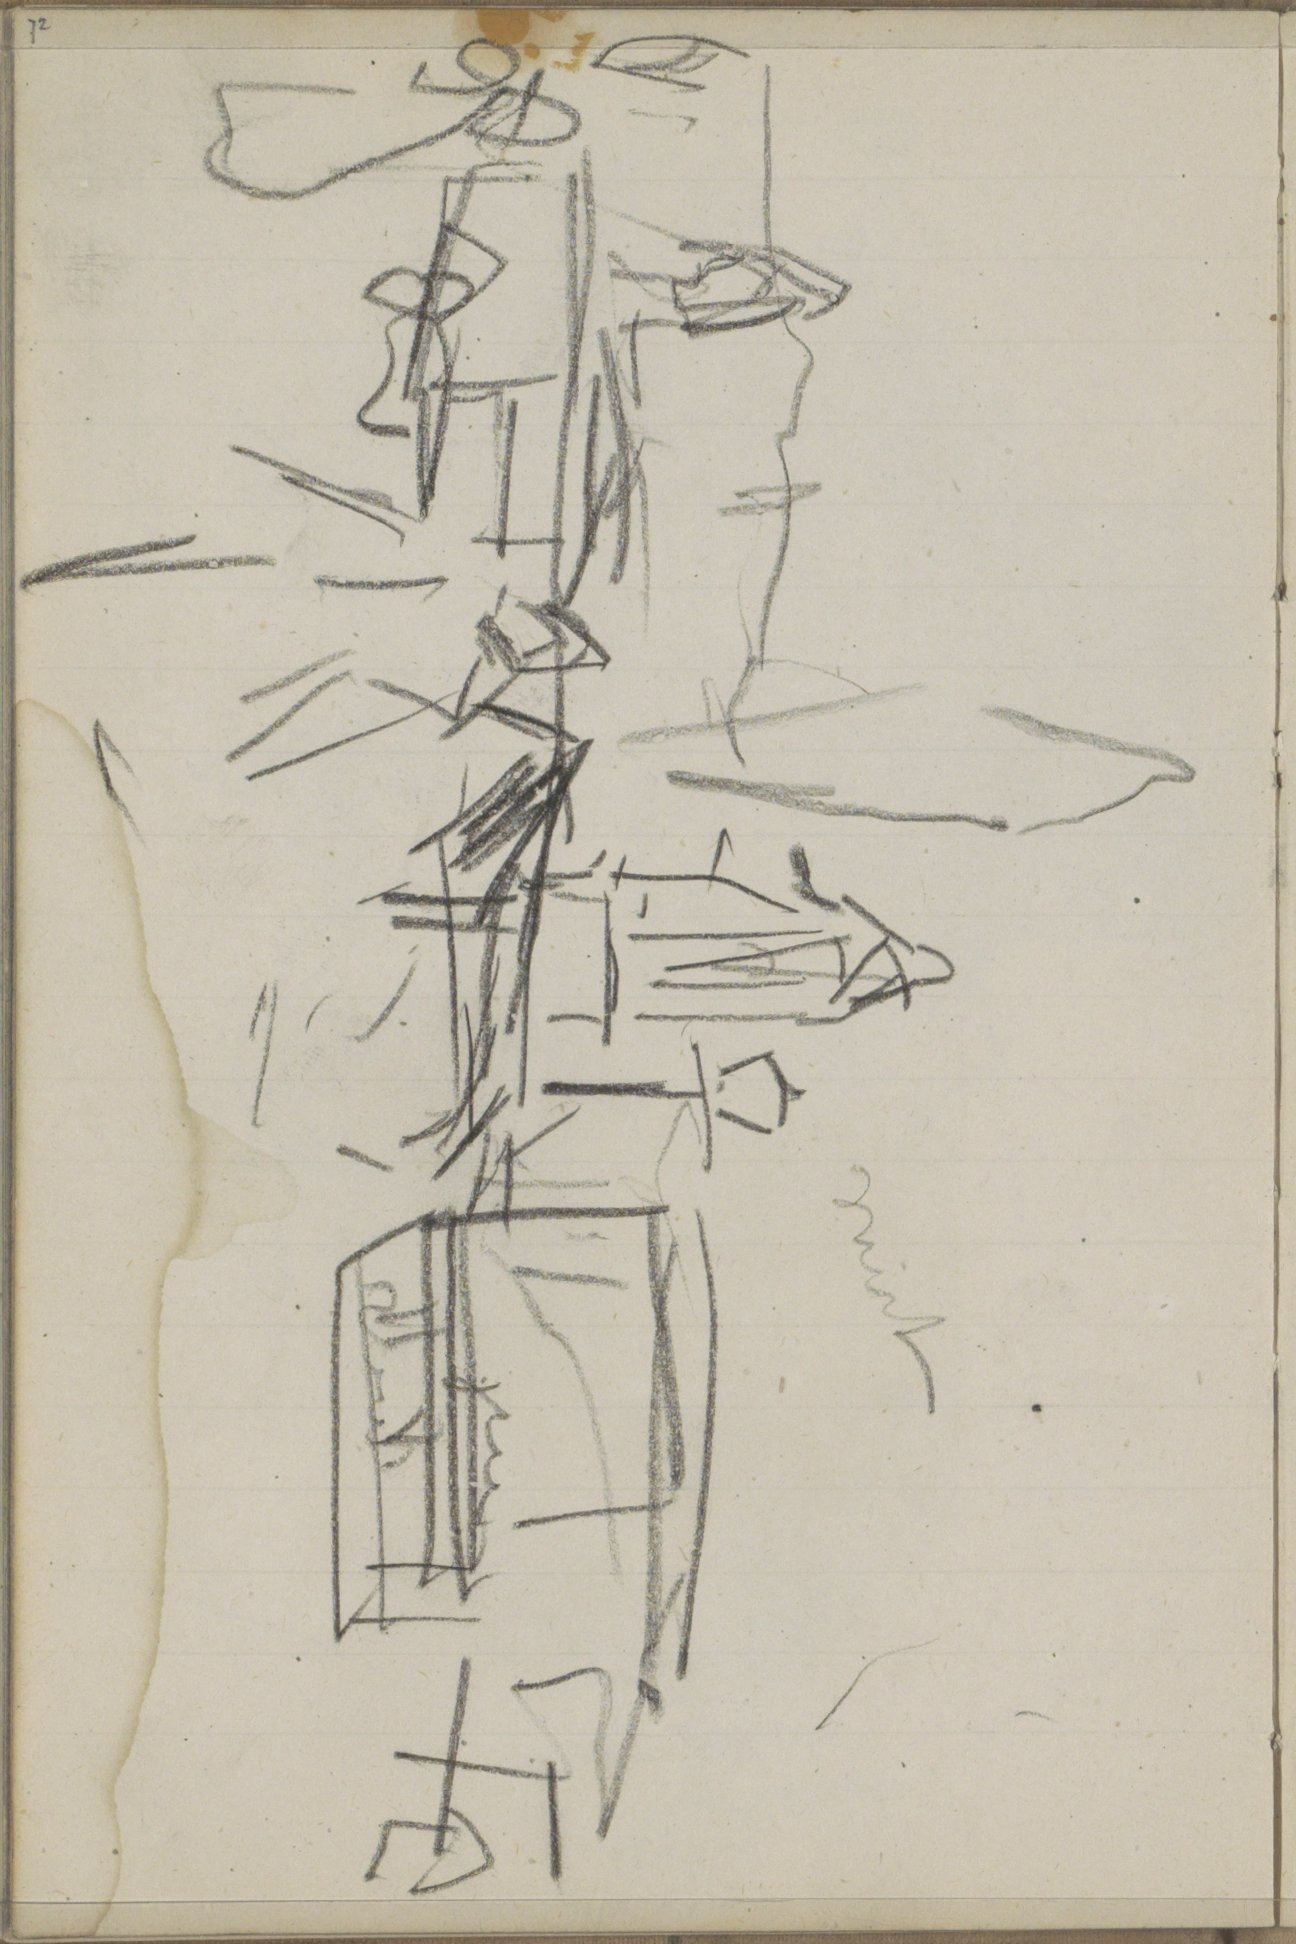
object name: sketchbook leaf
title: Straat met een monument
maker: marius bauer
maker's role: draughtsman, print maker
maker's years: 1867-1932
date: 1888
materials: chalk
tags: monument, statue, street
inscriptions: kleurnotitie, handgeschreven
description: Pagina 72 uit een schetsboek met 49 bladen.